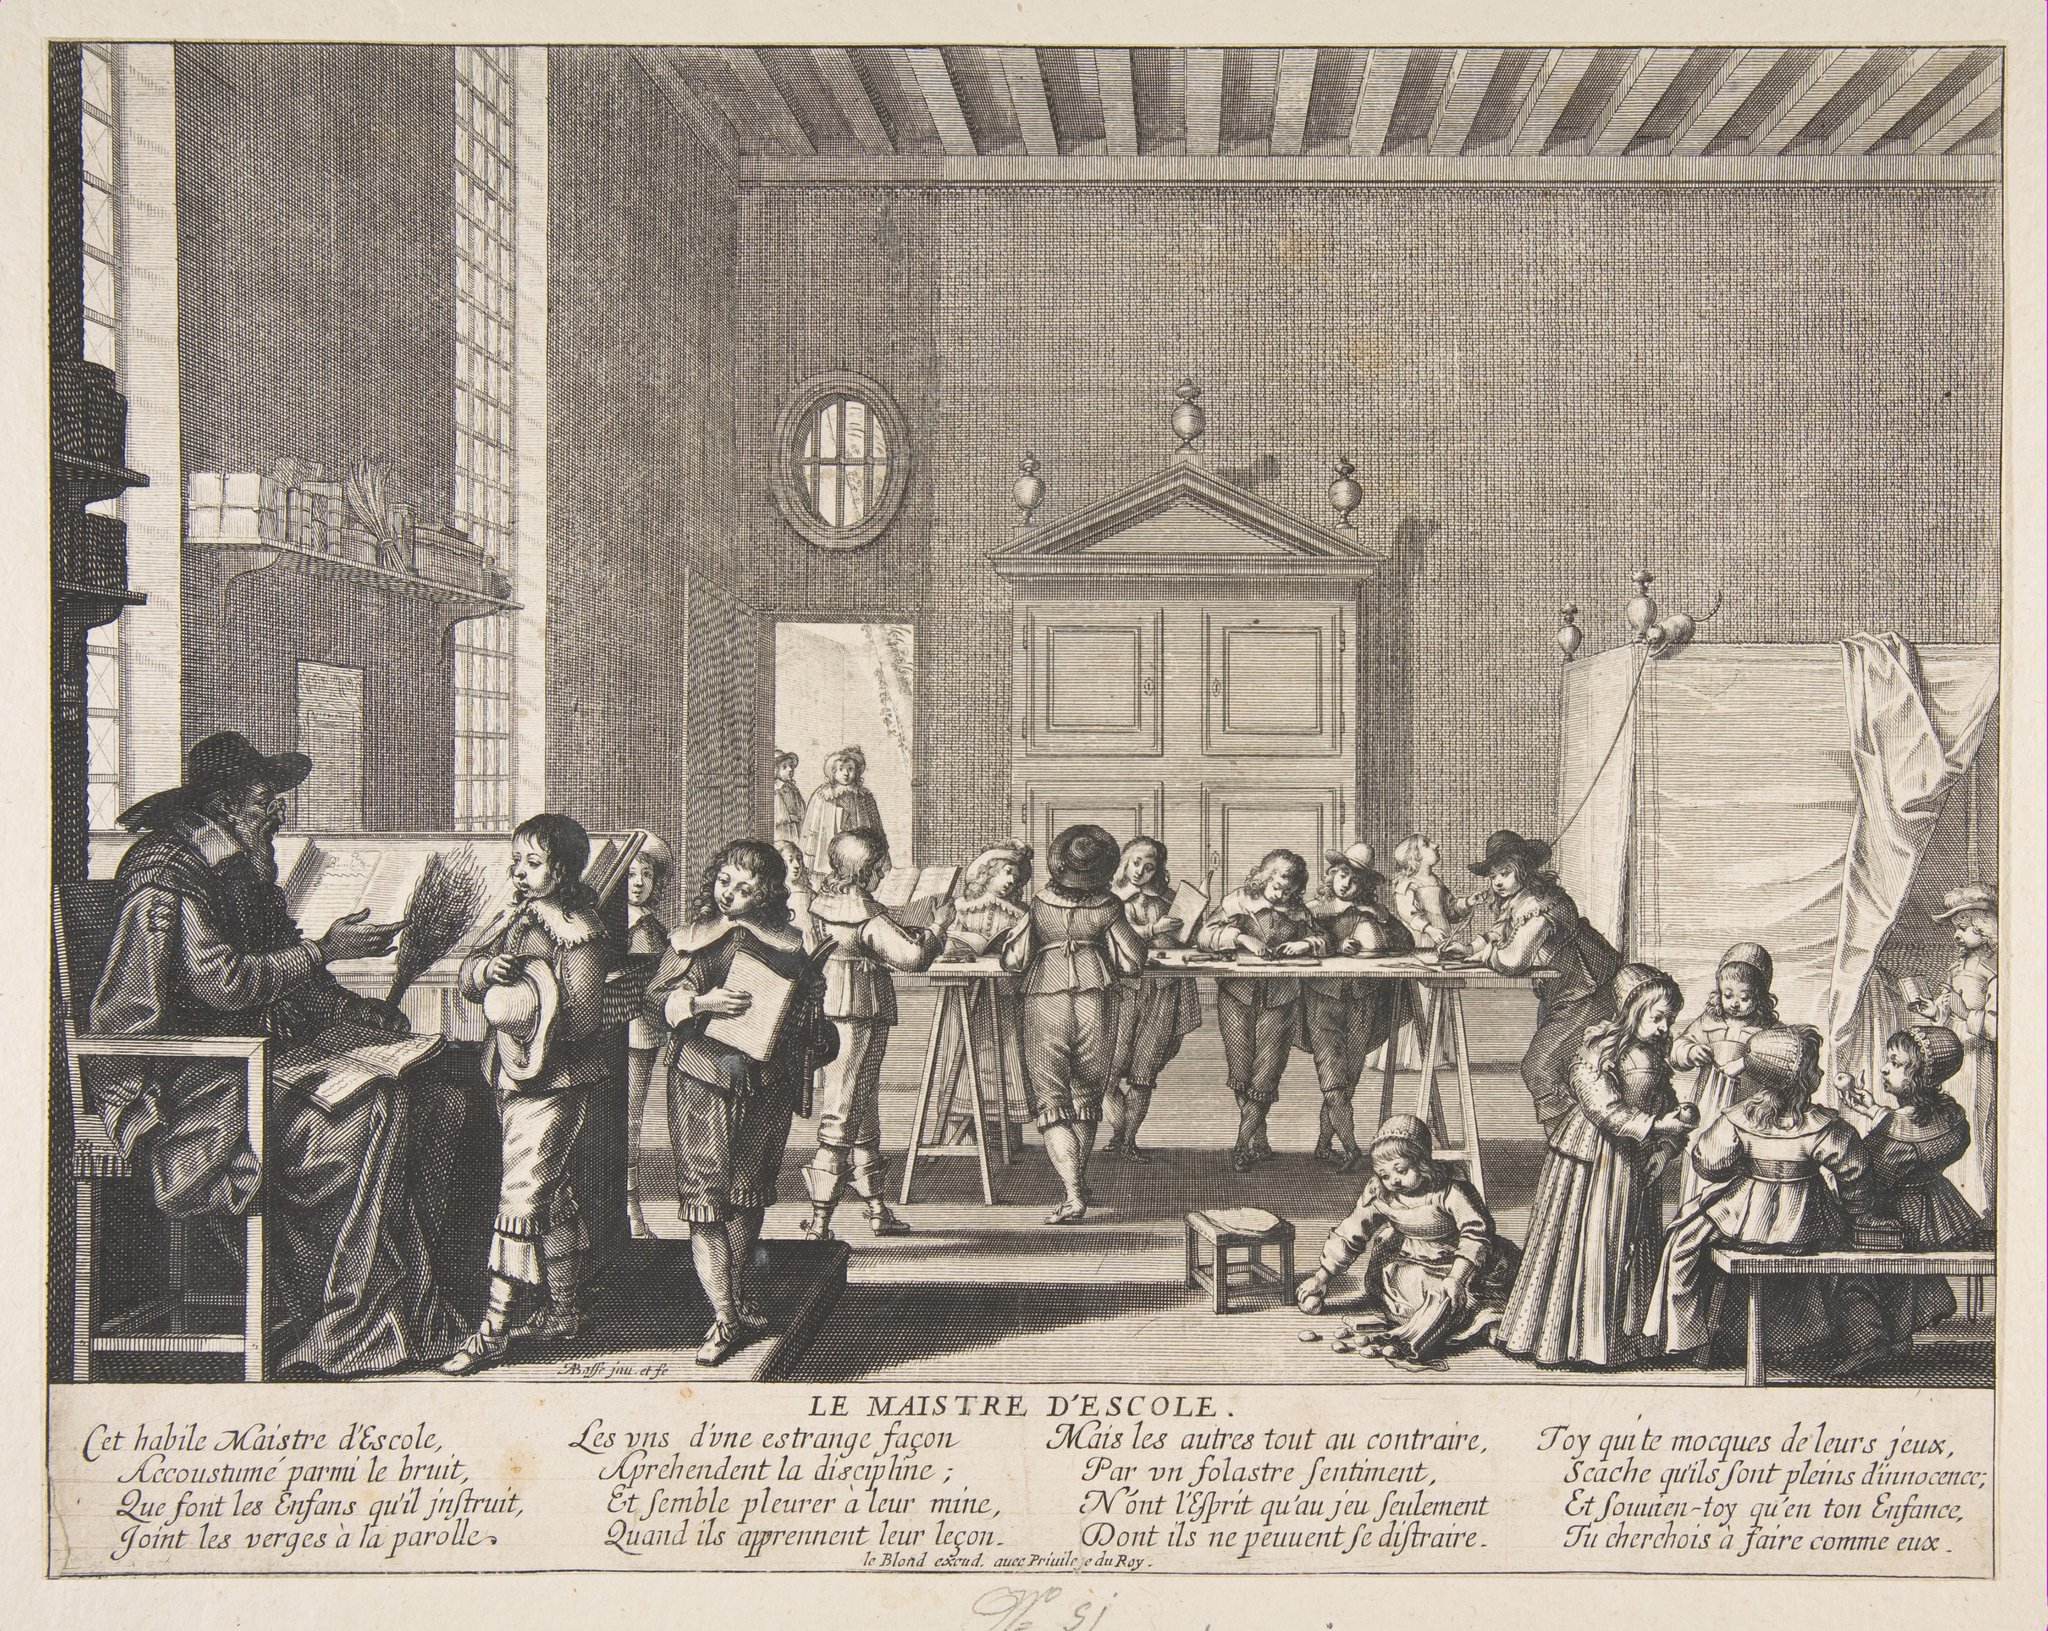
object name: print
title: The School Master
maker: abraham bosse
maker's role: artist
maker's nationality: french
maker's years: 1602-1676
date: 1638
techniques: etching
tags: schools,interiors,children,men,students,teachers